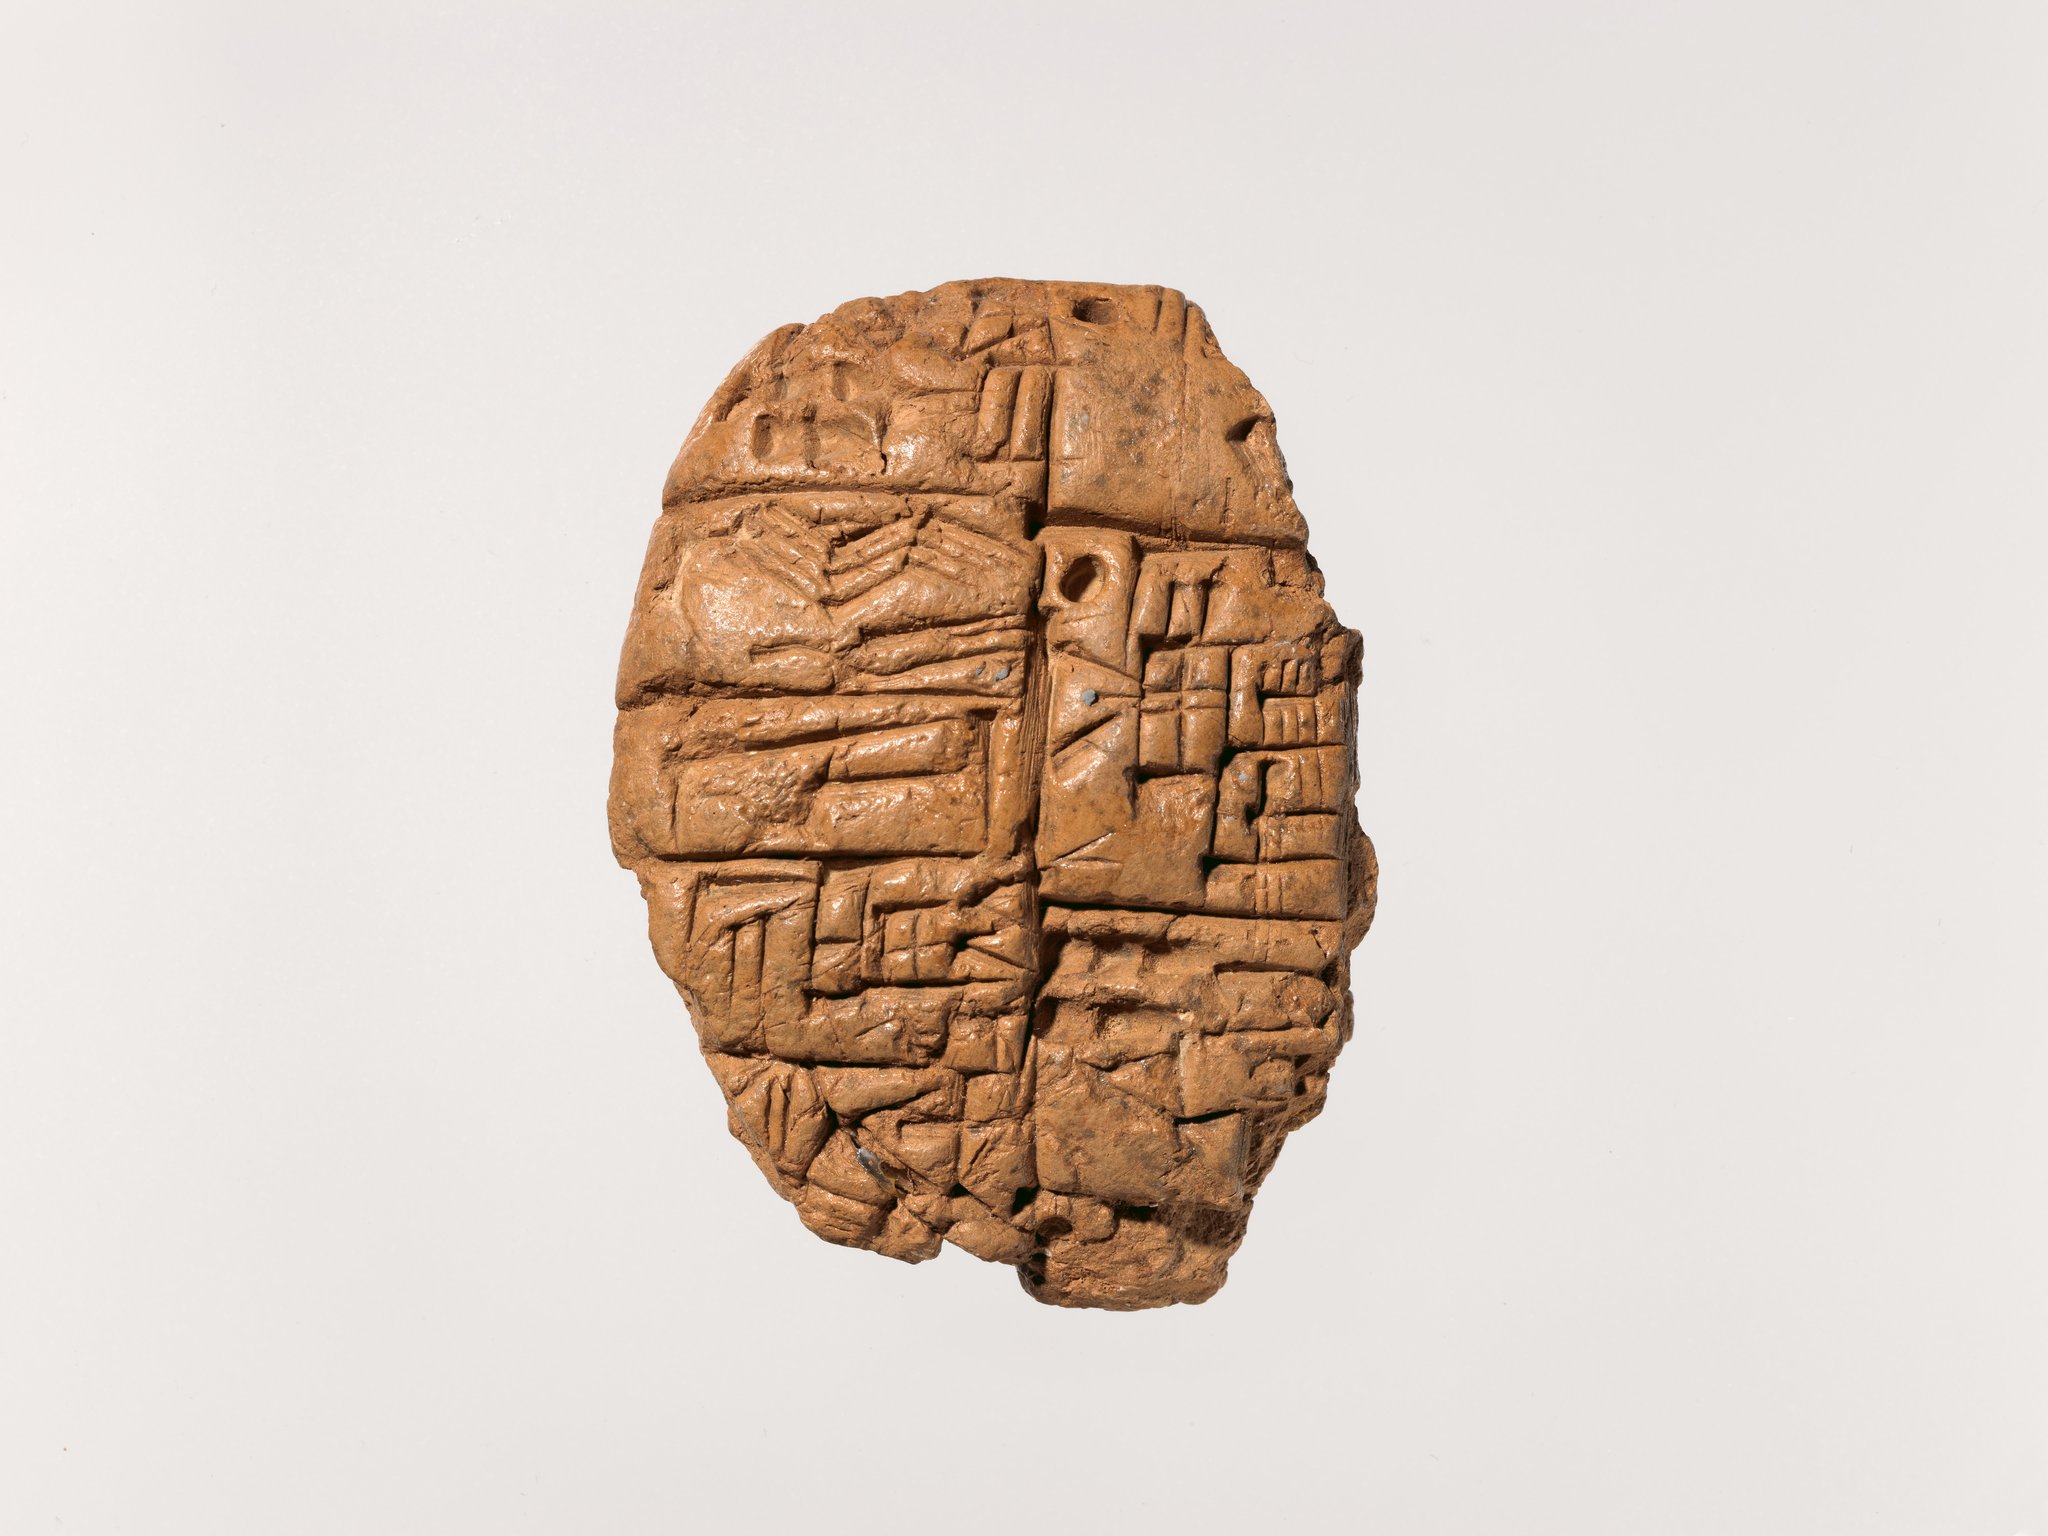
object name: cuneiform tablet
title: Cuneiform tablet: distribution of copper knives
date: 2600-2350 BCE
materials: clay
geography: mesopotamia